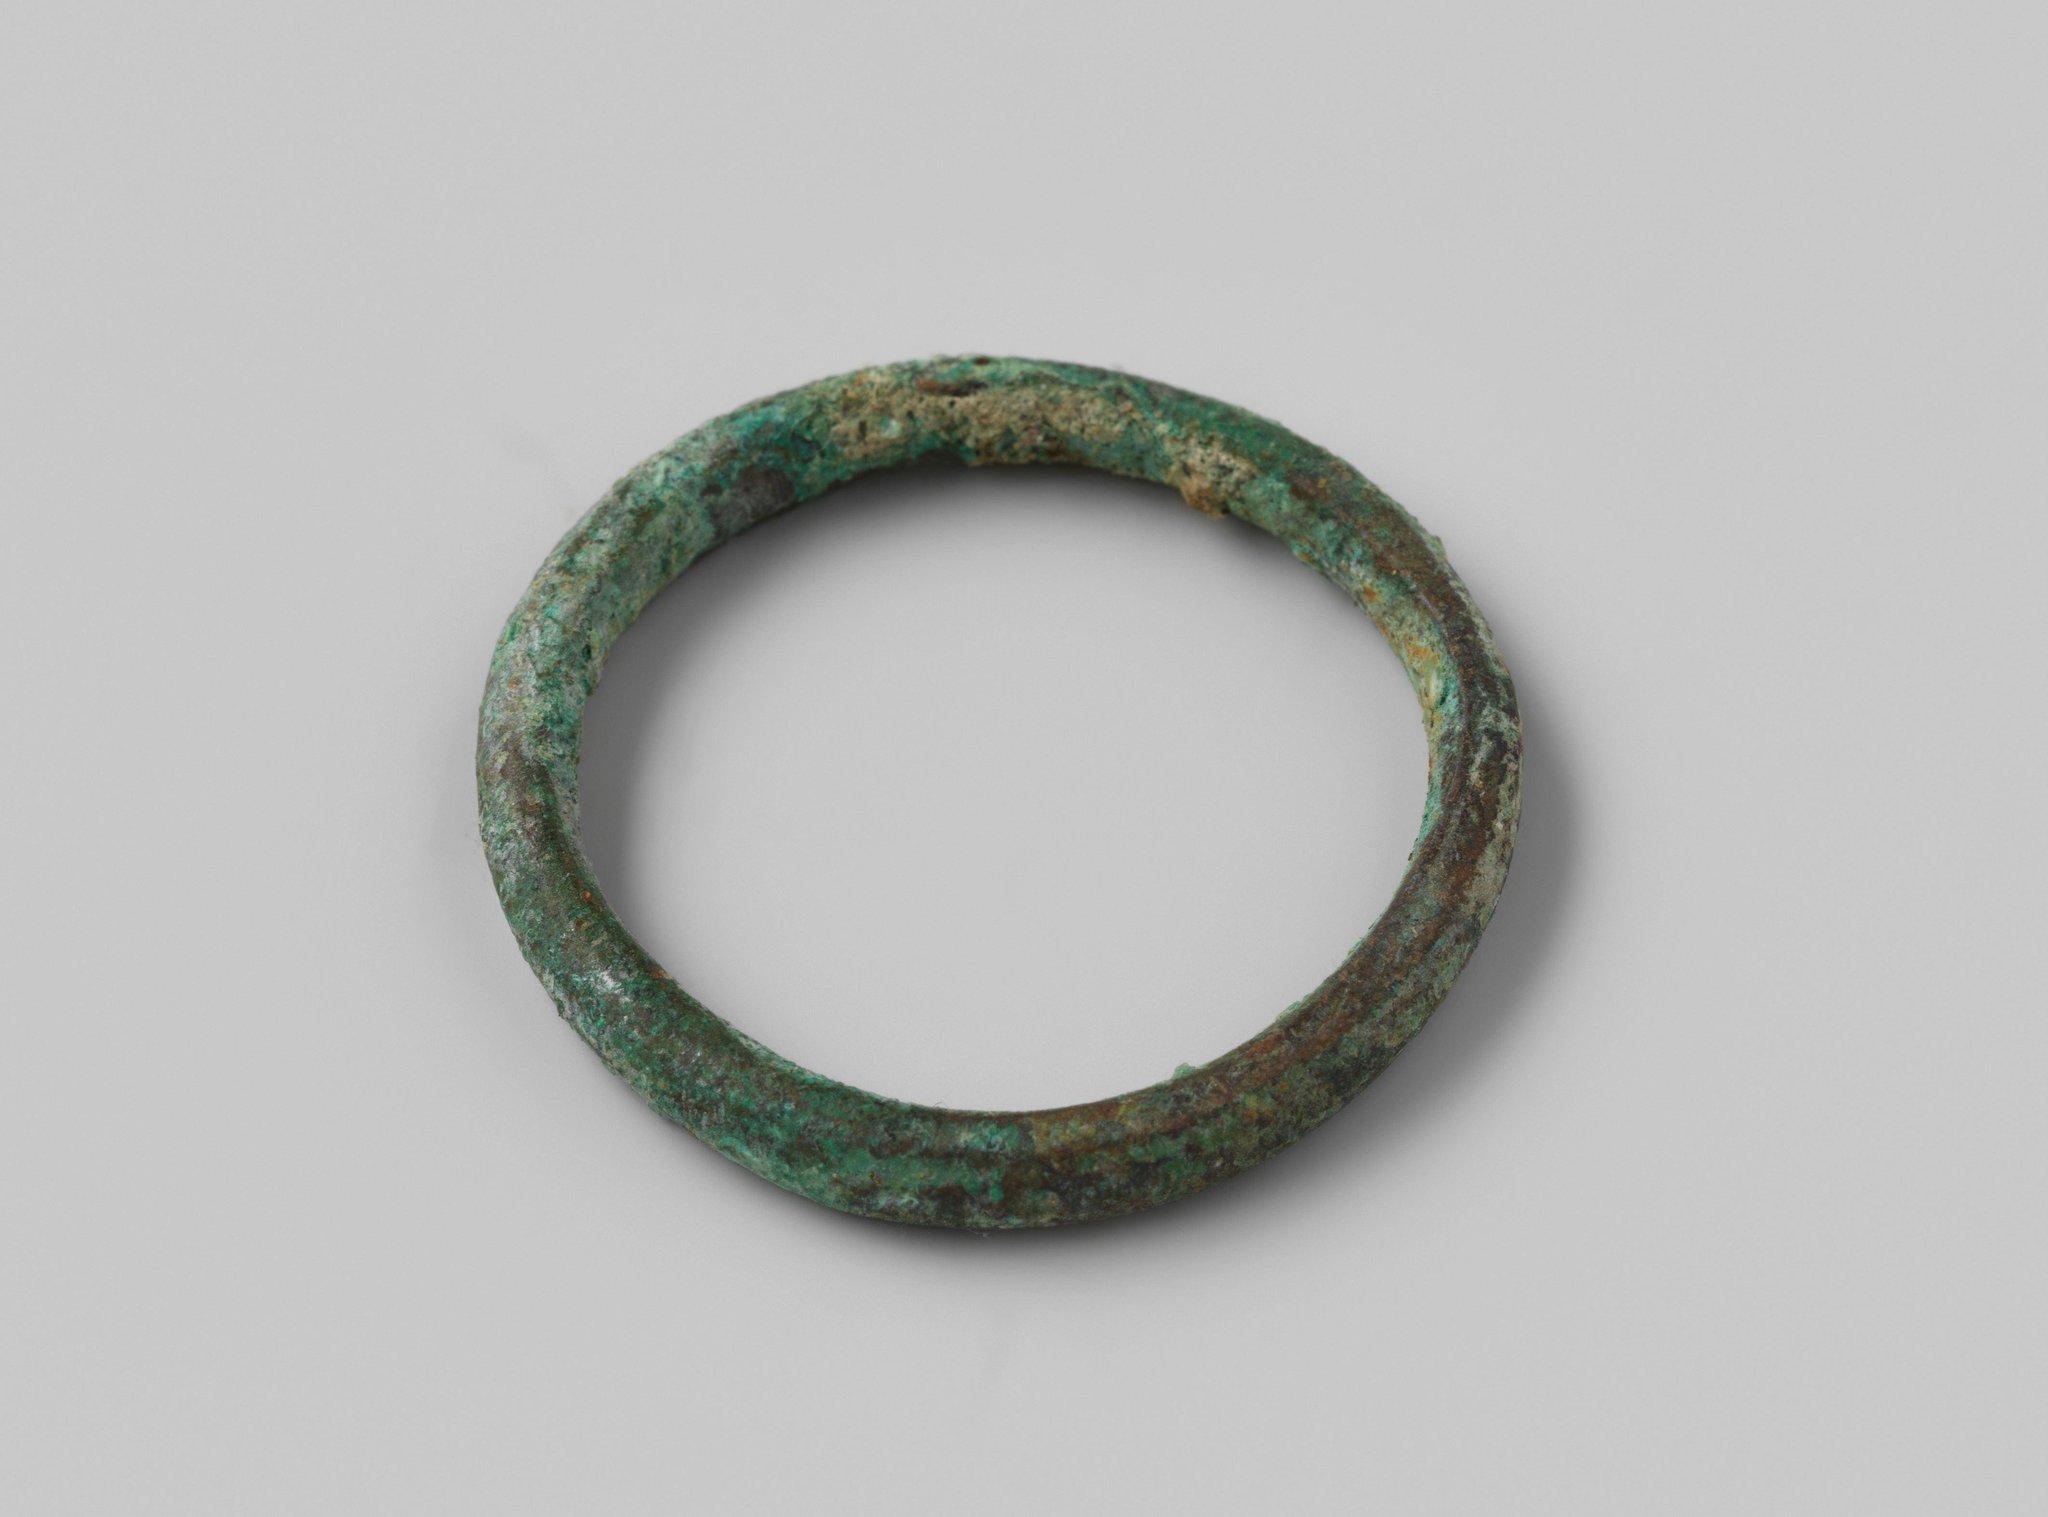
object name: fragment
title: Ringvormig fragment uit het wrak van de Oost-Indiëvaarder Hollandia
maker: Anonymous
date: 1700-1743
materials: copper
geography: netherlands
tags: verenigde oostindische compagnie, hollandia (schip), annet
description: Varied parts or fragments, rings or ring-shaped fragments; id. 80H1.